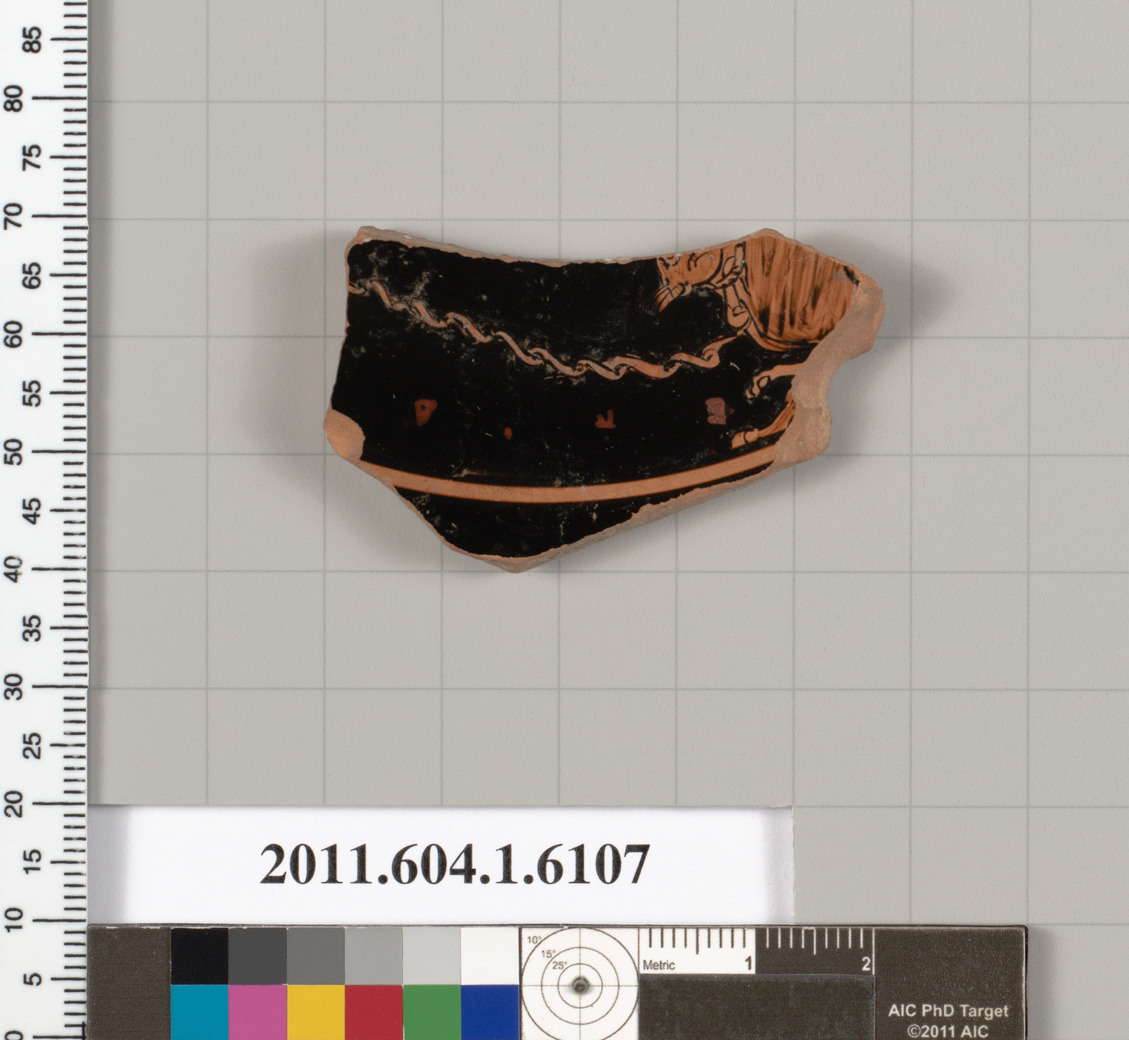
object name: kylix fragment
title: Terracotta fragment of a kylix (drinking cup)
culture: greek, attic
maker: epidromos painter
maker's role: artist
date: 520-500 BCE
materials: terracotta